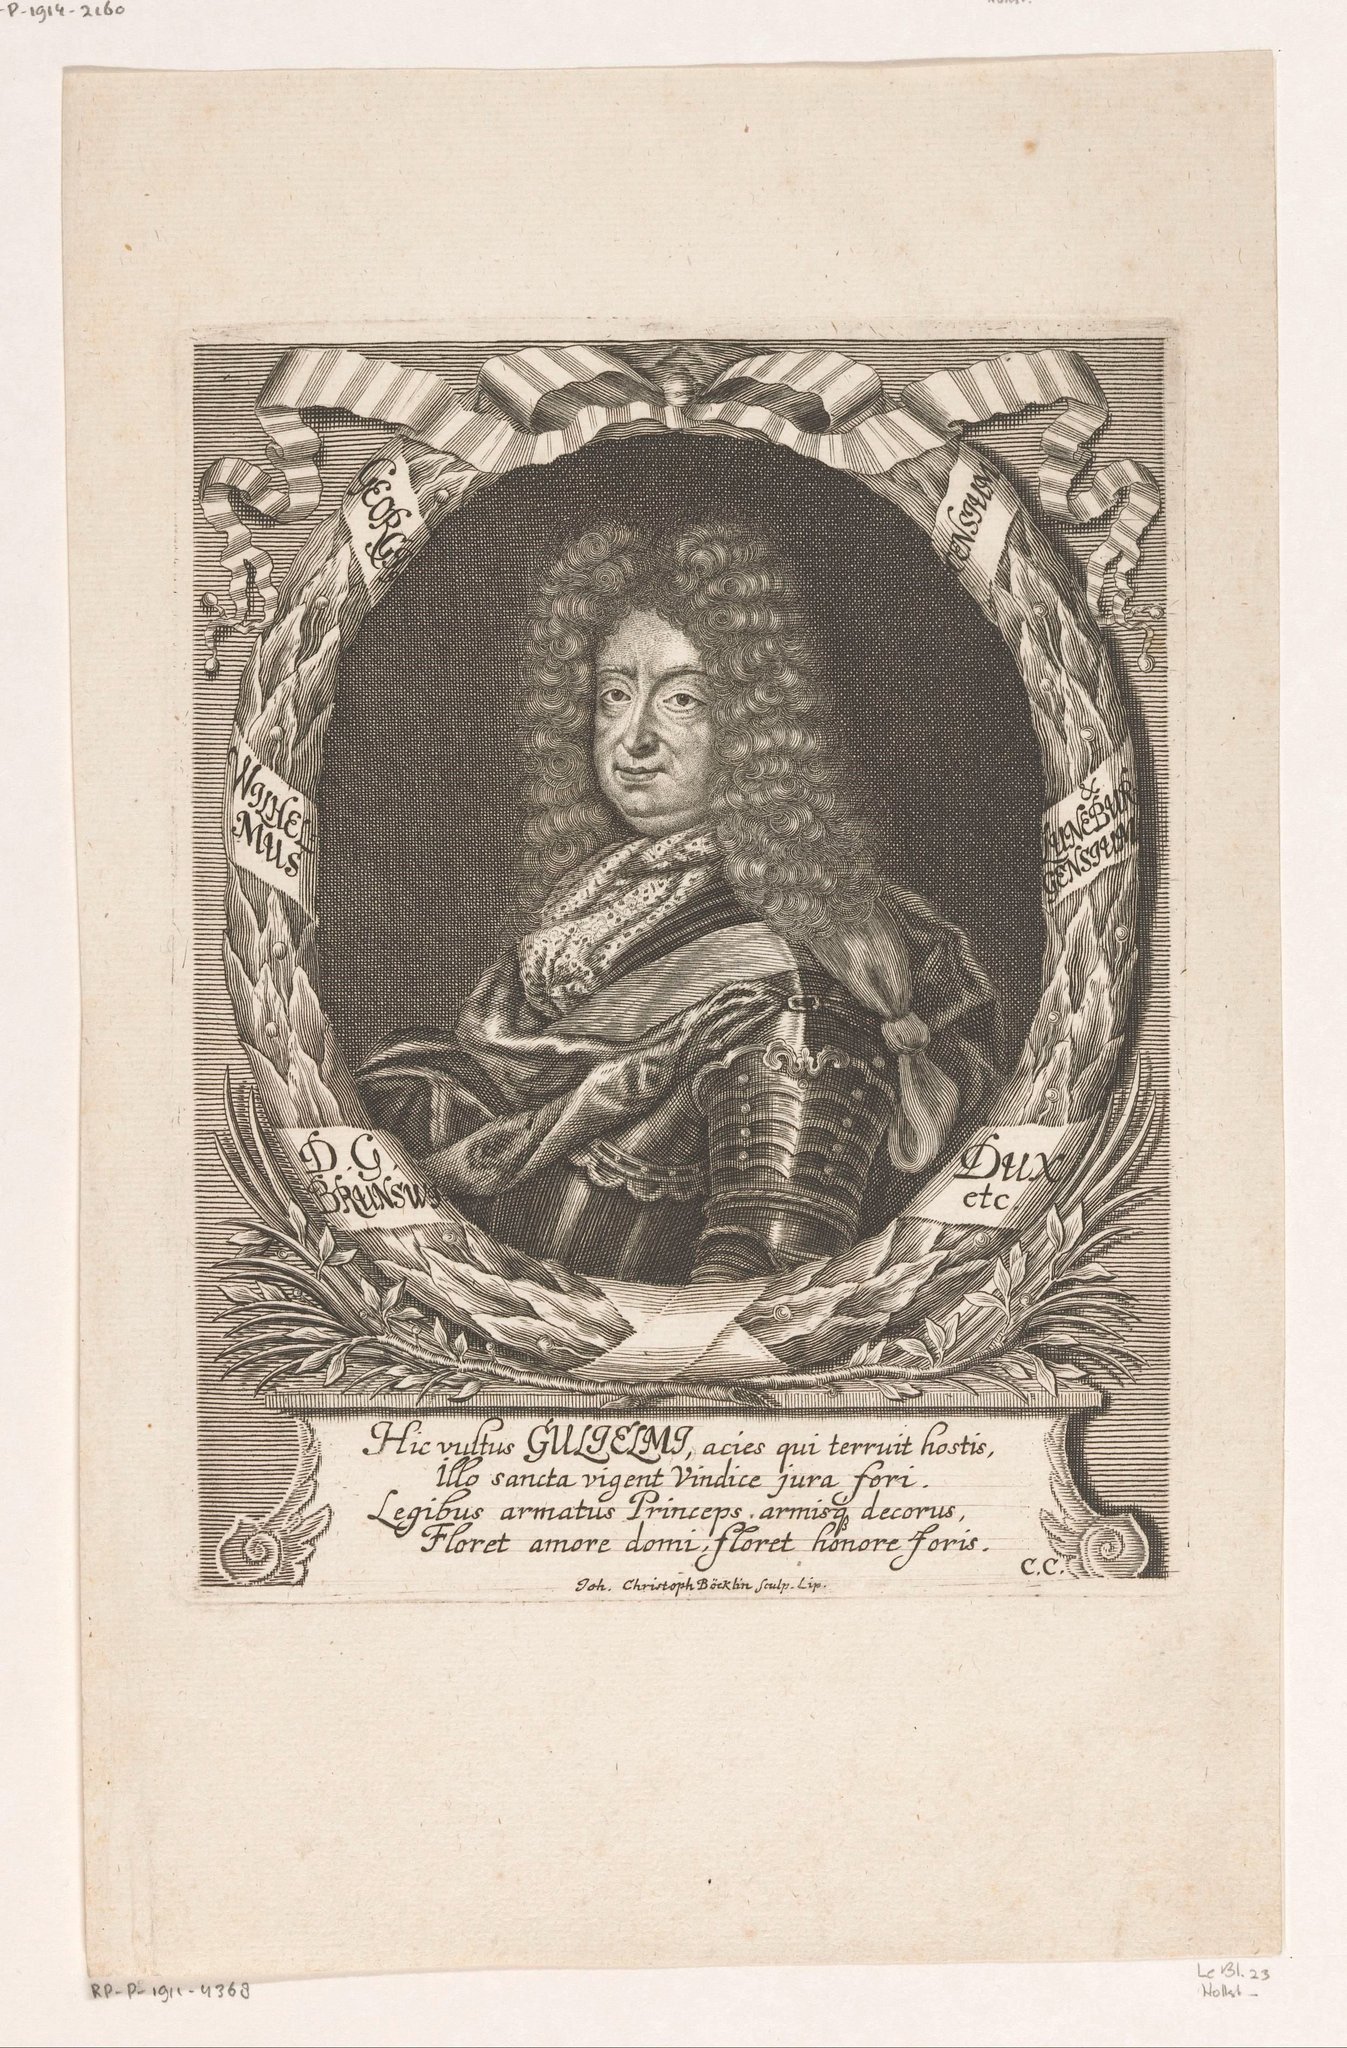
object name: print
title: Portret van Georg Wilhelm von Braunschweig-Lüneburg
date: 1698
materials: paper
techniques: engraving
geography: leipzig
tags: armour, historical persons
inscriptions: collector's mark: Lugt 2228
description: Prent ook gebruikt in: Sämtliche Hochfürstl. Braunschw.Lüneb. Cellischen Theils Gerichts-Ordnungen (...). Celle en Leipzig: Hieronymus Friedrich Hoffmann, 1698.